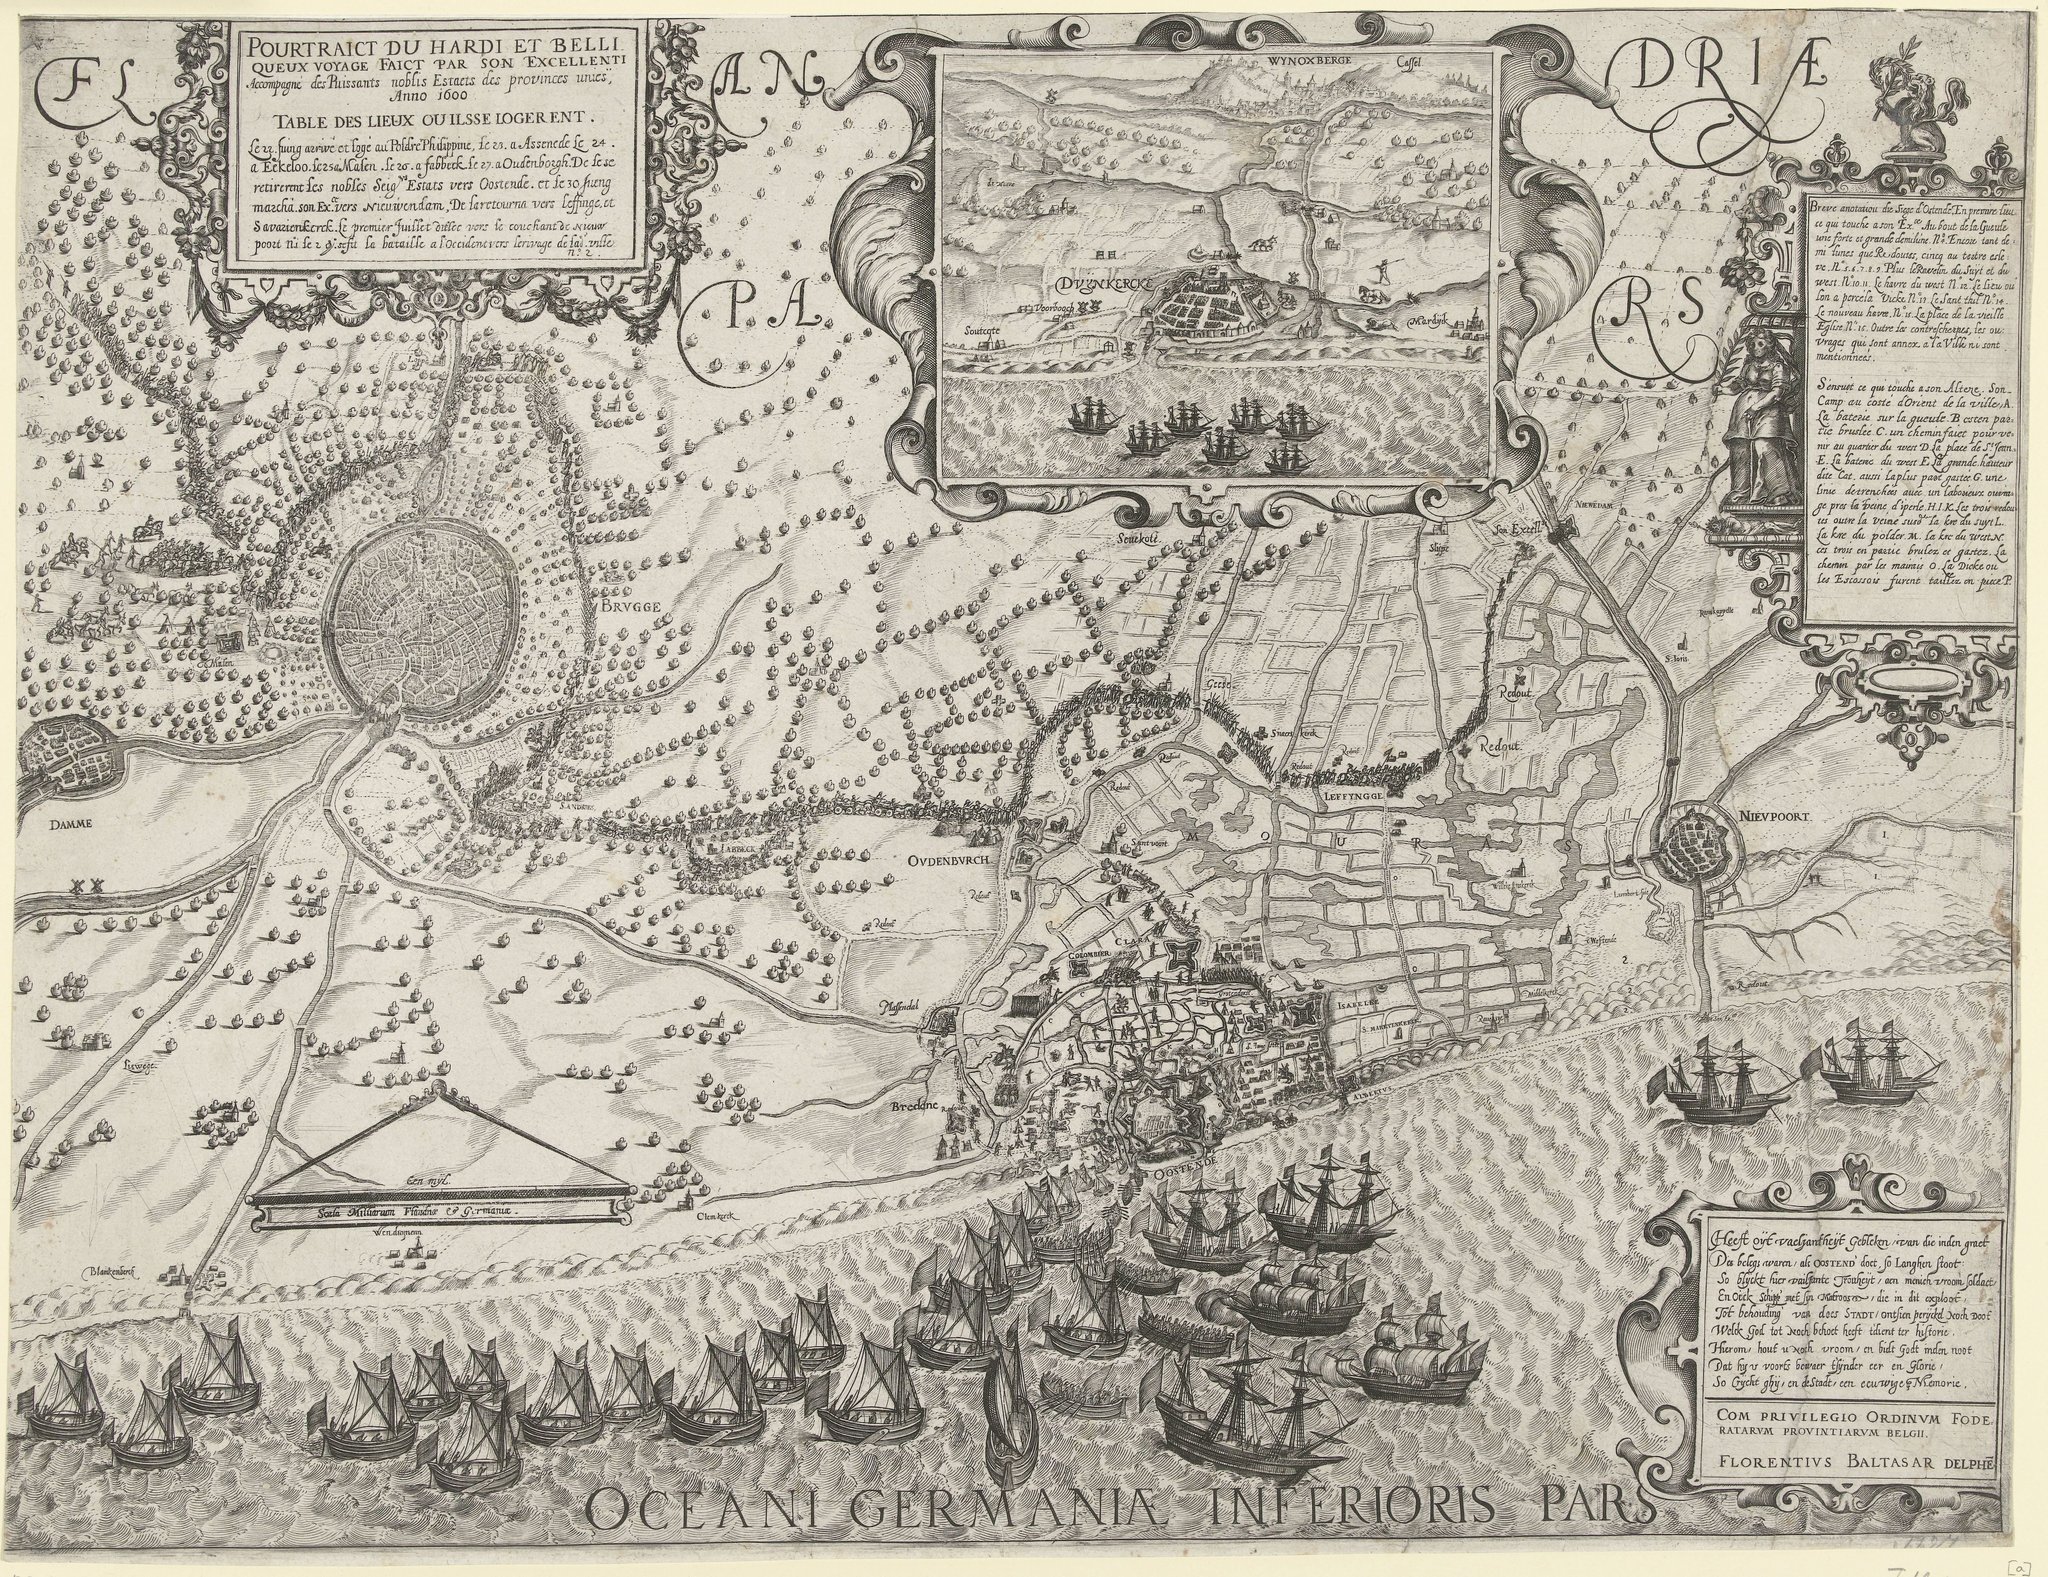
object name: map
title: Tocht van het leger van Maurits naar Oostende (rechterblad), 1600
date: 1600-1601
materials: paper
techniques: engraving, etching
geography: delft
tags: troop movements, transportation, maps of separate countries or regions, bruges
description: Tocht van het Staatse leger onder prins Maurits naar Oostende, 19-27 juni 1600. Rechterhelft van twee bladen. De Staatse vloot voor Oostende. Boven trekt het Staatse leger door Vlaanderen, om Brugge en Oostende heen in de richting van Nieuwpoort. Bovenaan cartouches met de titel, een gezicht op Duinkerke en opschriften en legenda in het Frans. Onderaan een vers in het Nederlands en de privilege.